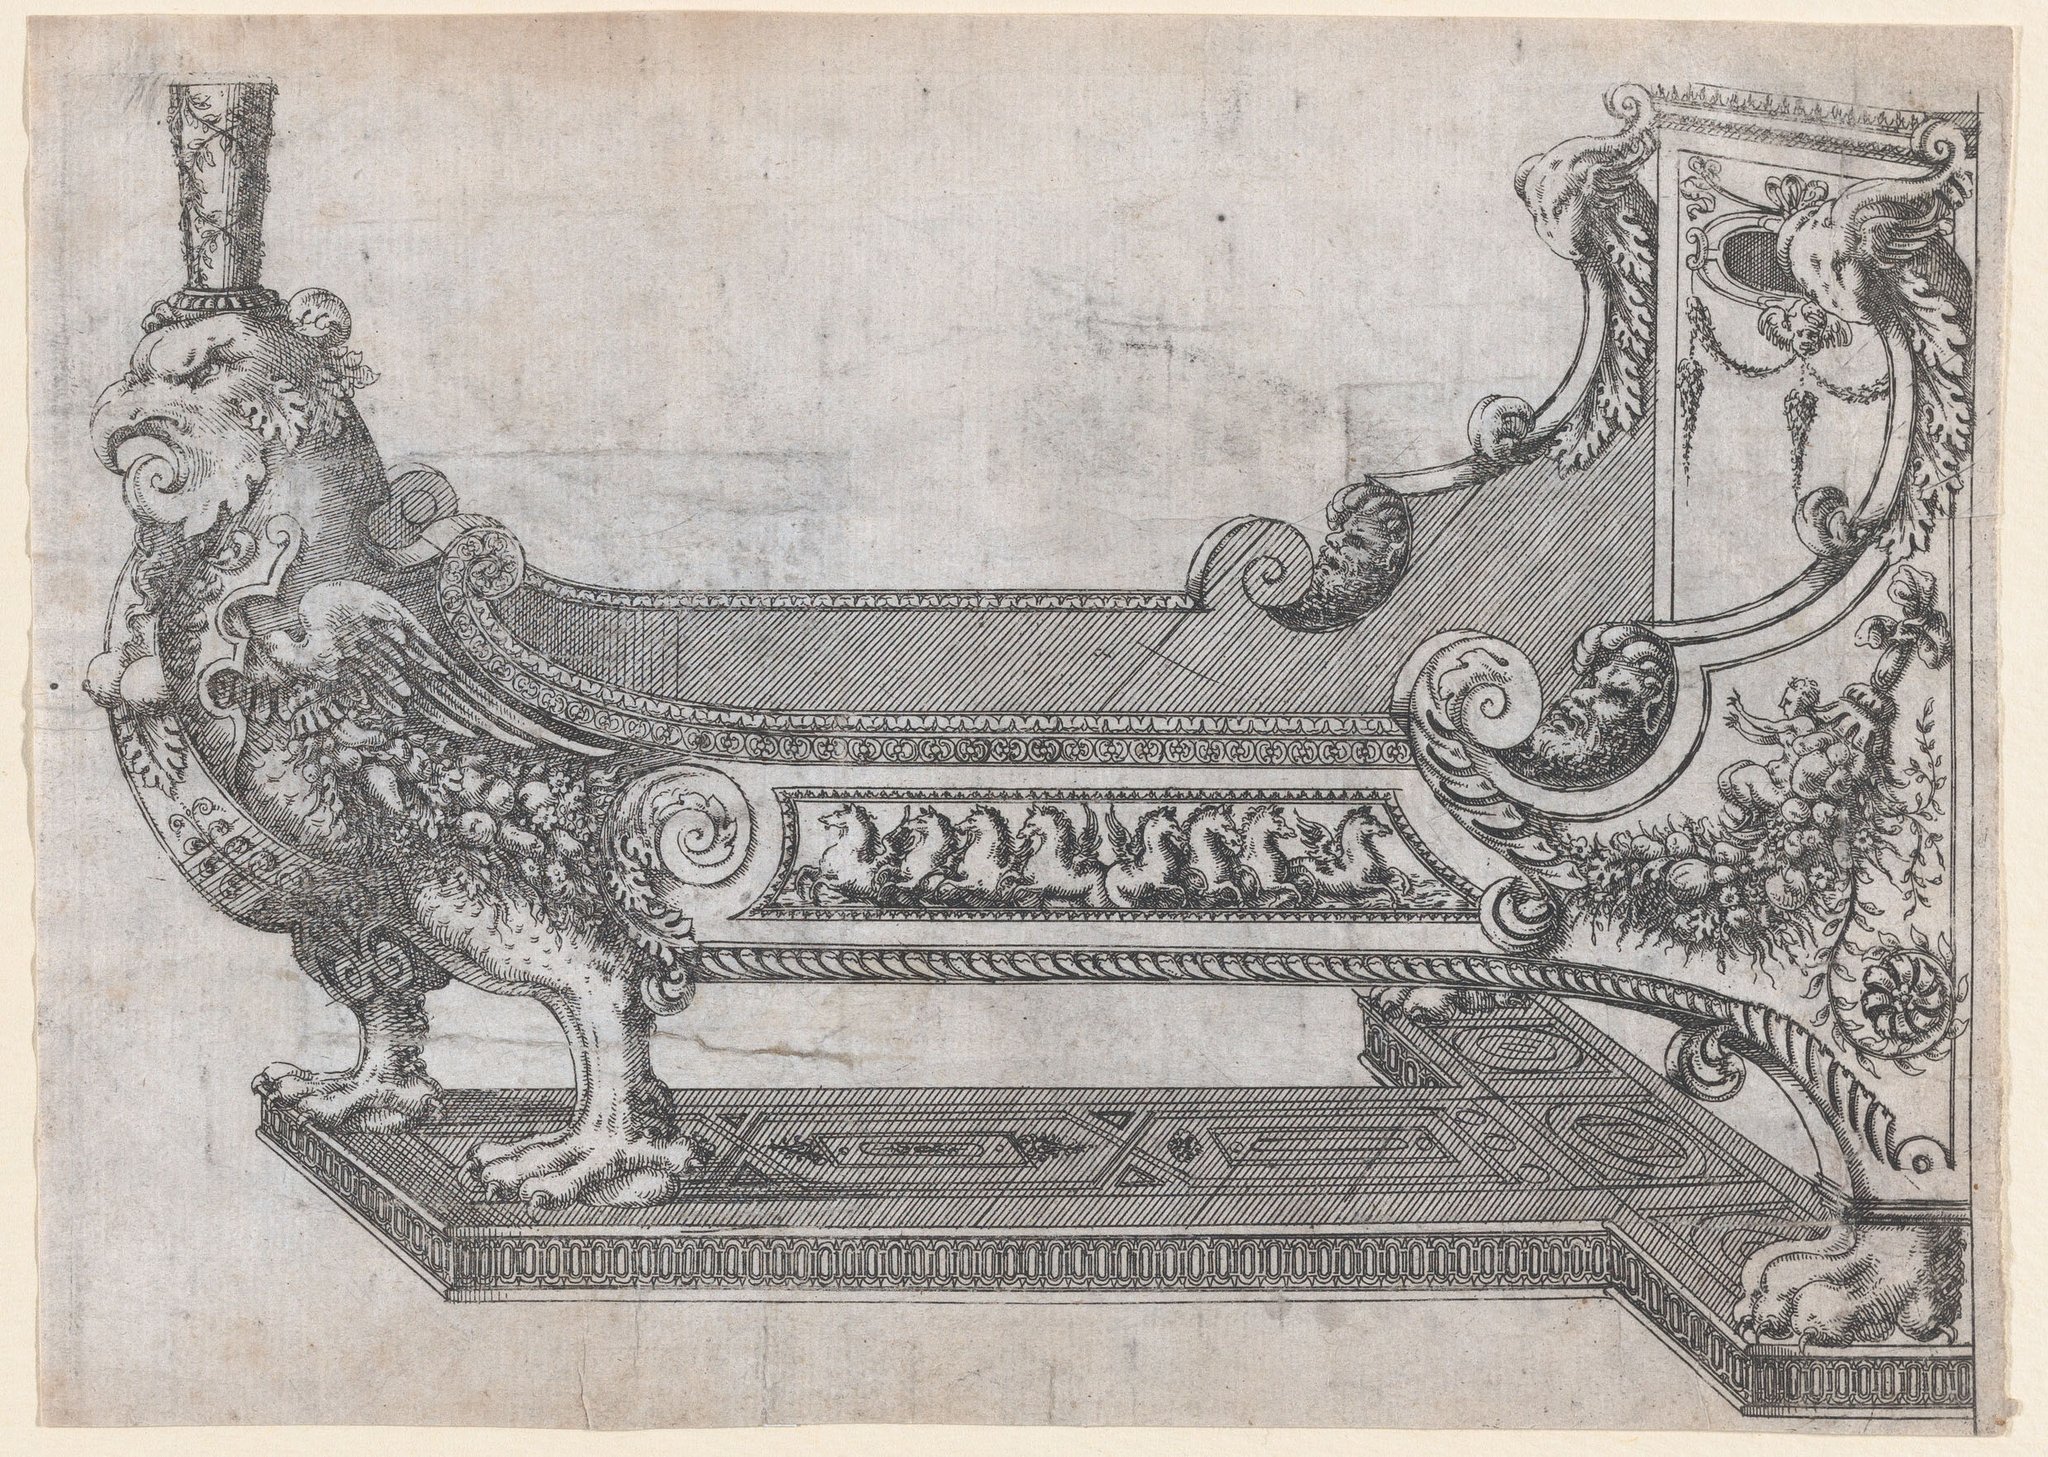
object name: print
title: Design for a Bed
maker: jacques androuet du cerceau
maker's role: artist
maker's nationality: french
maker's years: 1510-1585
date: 1565-1570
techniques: etching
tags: beds